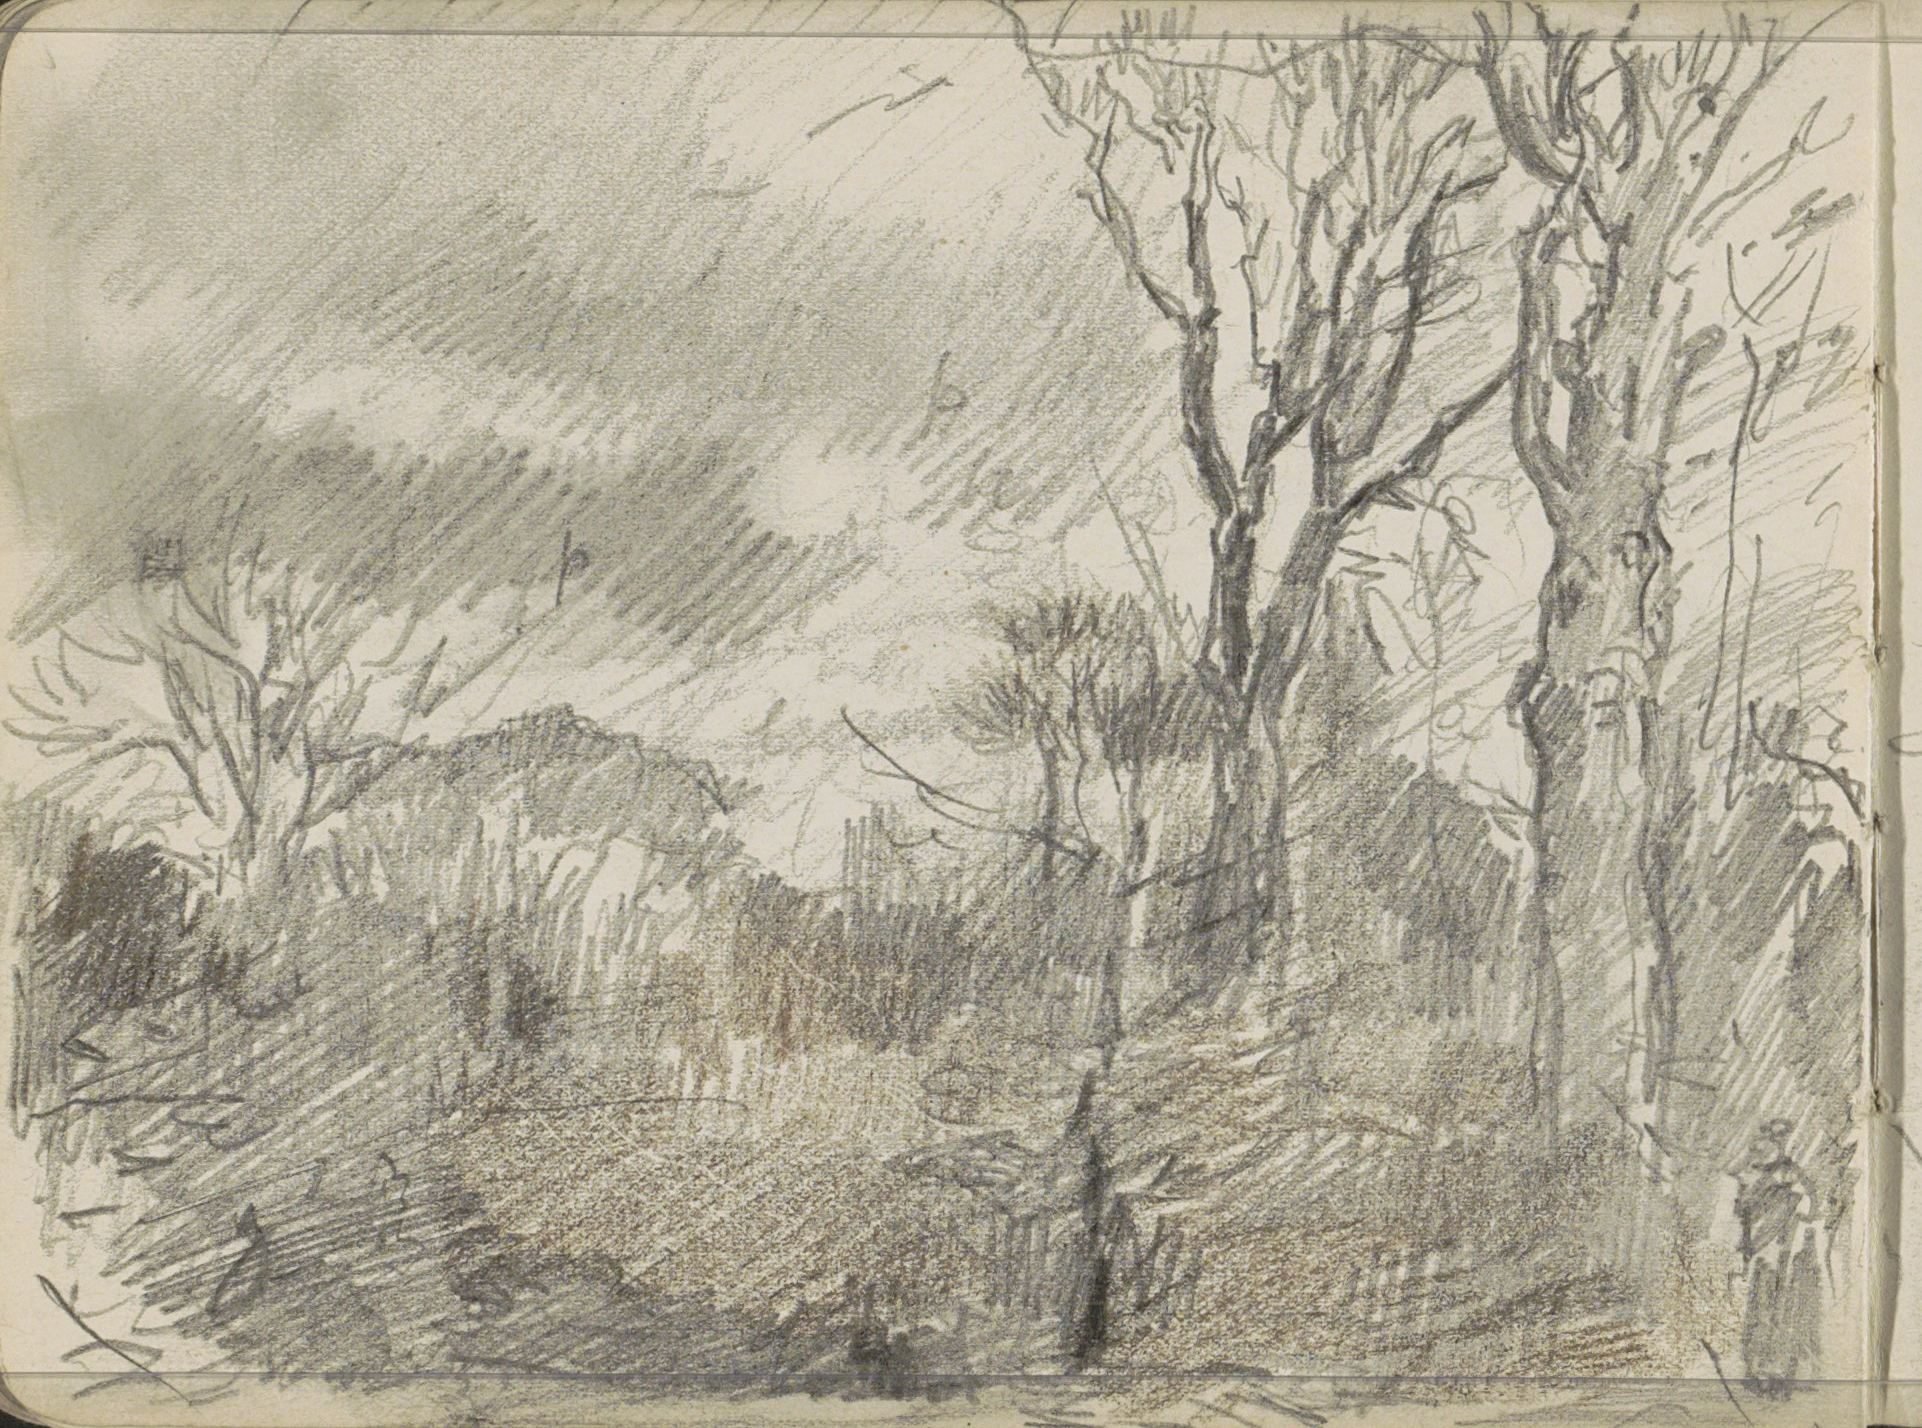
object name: sketchbook leaf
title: Bosgezicht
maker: johan antonie de jonge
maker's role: draughtsman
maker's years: 1864-1927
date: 1884-1927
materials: chalk, paper, pencil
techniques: stumping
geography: south holland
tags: forest, wood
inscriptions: kleurnotitie, handgeschreven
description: Bosgezicht. Vooraan een vrouw. Los blad verso tussen blad 23 en blad 24 in een schetsboek met 33 bladen aangetroffen.